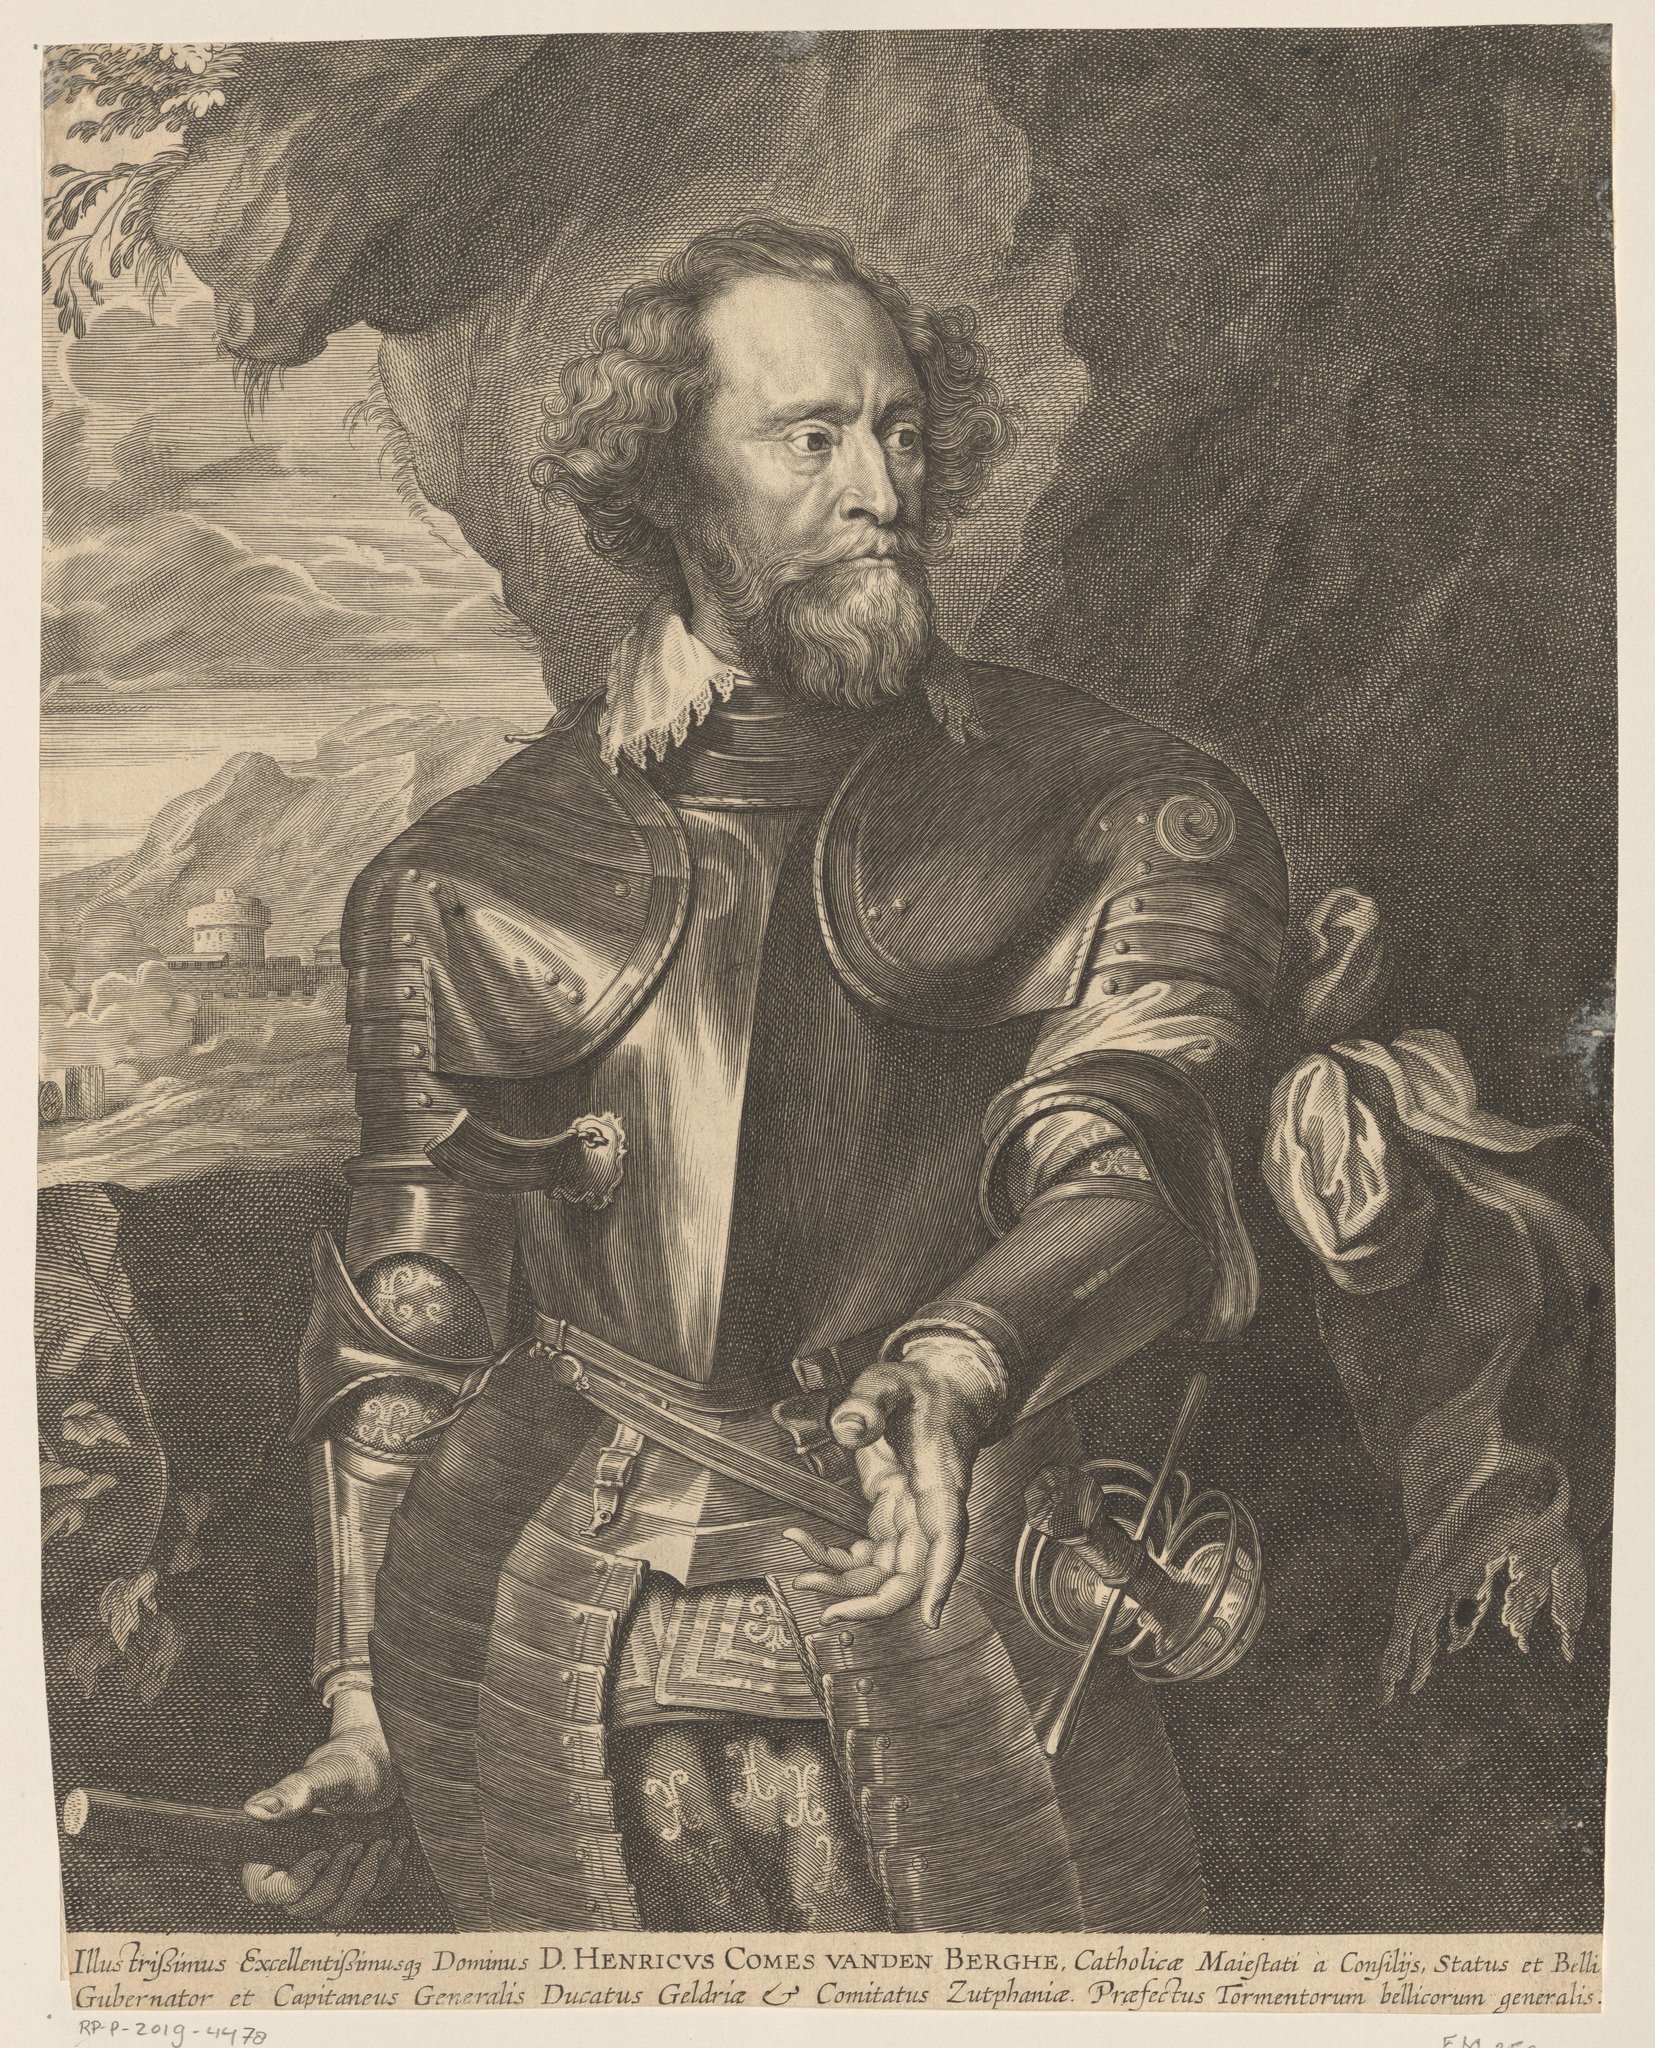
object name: print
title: Portret van Hendrik, graaf van den Bergh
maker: paulus pontius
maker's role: draughtsman, print maker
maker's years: 1603-1658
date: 1629-1658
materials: paper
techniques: engraving, etching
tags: earl, armour, historical persons, baton of general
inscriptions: collector's mark: Lugt 2228